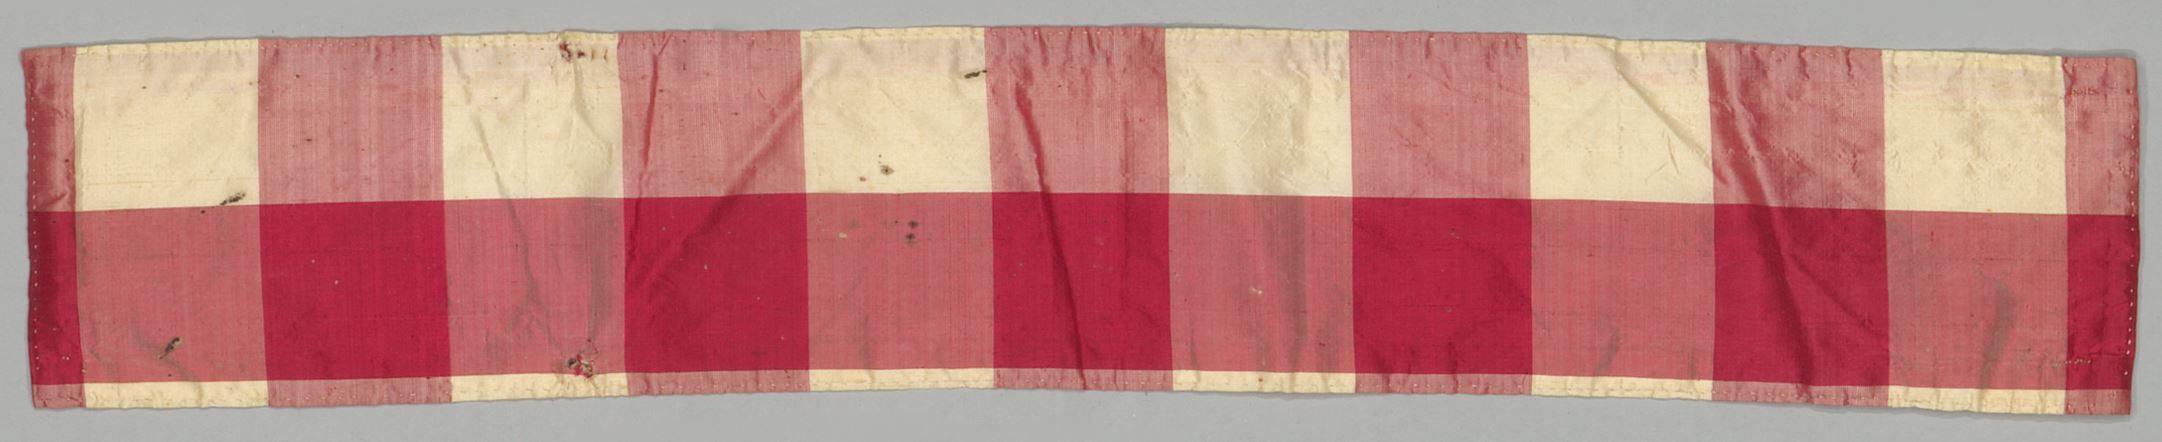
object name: tieback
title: Embrasse van rood-wit geblokte zijde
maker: Anonymous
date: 1776-1800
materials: linen, silk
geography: northern netherlands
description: Embrasse van rood-wit geblokte zijde, gevoerd met wit linnen en met twee stel metalen haken en ogen.